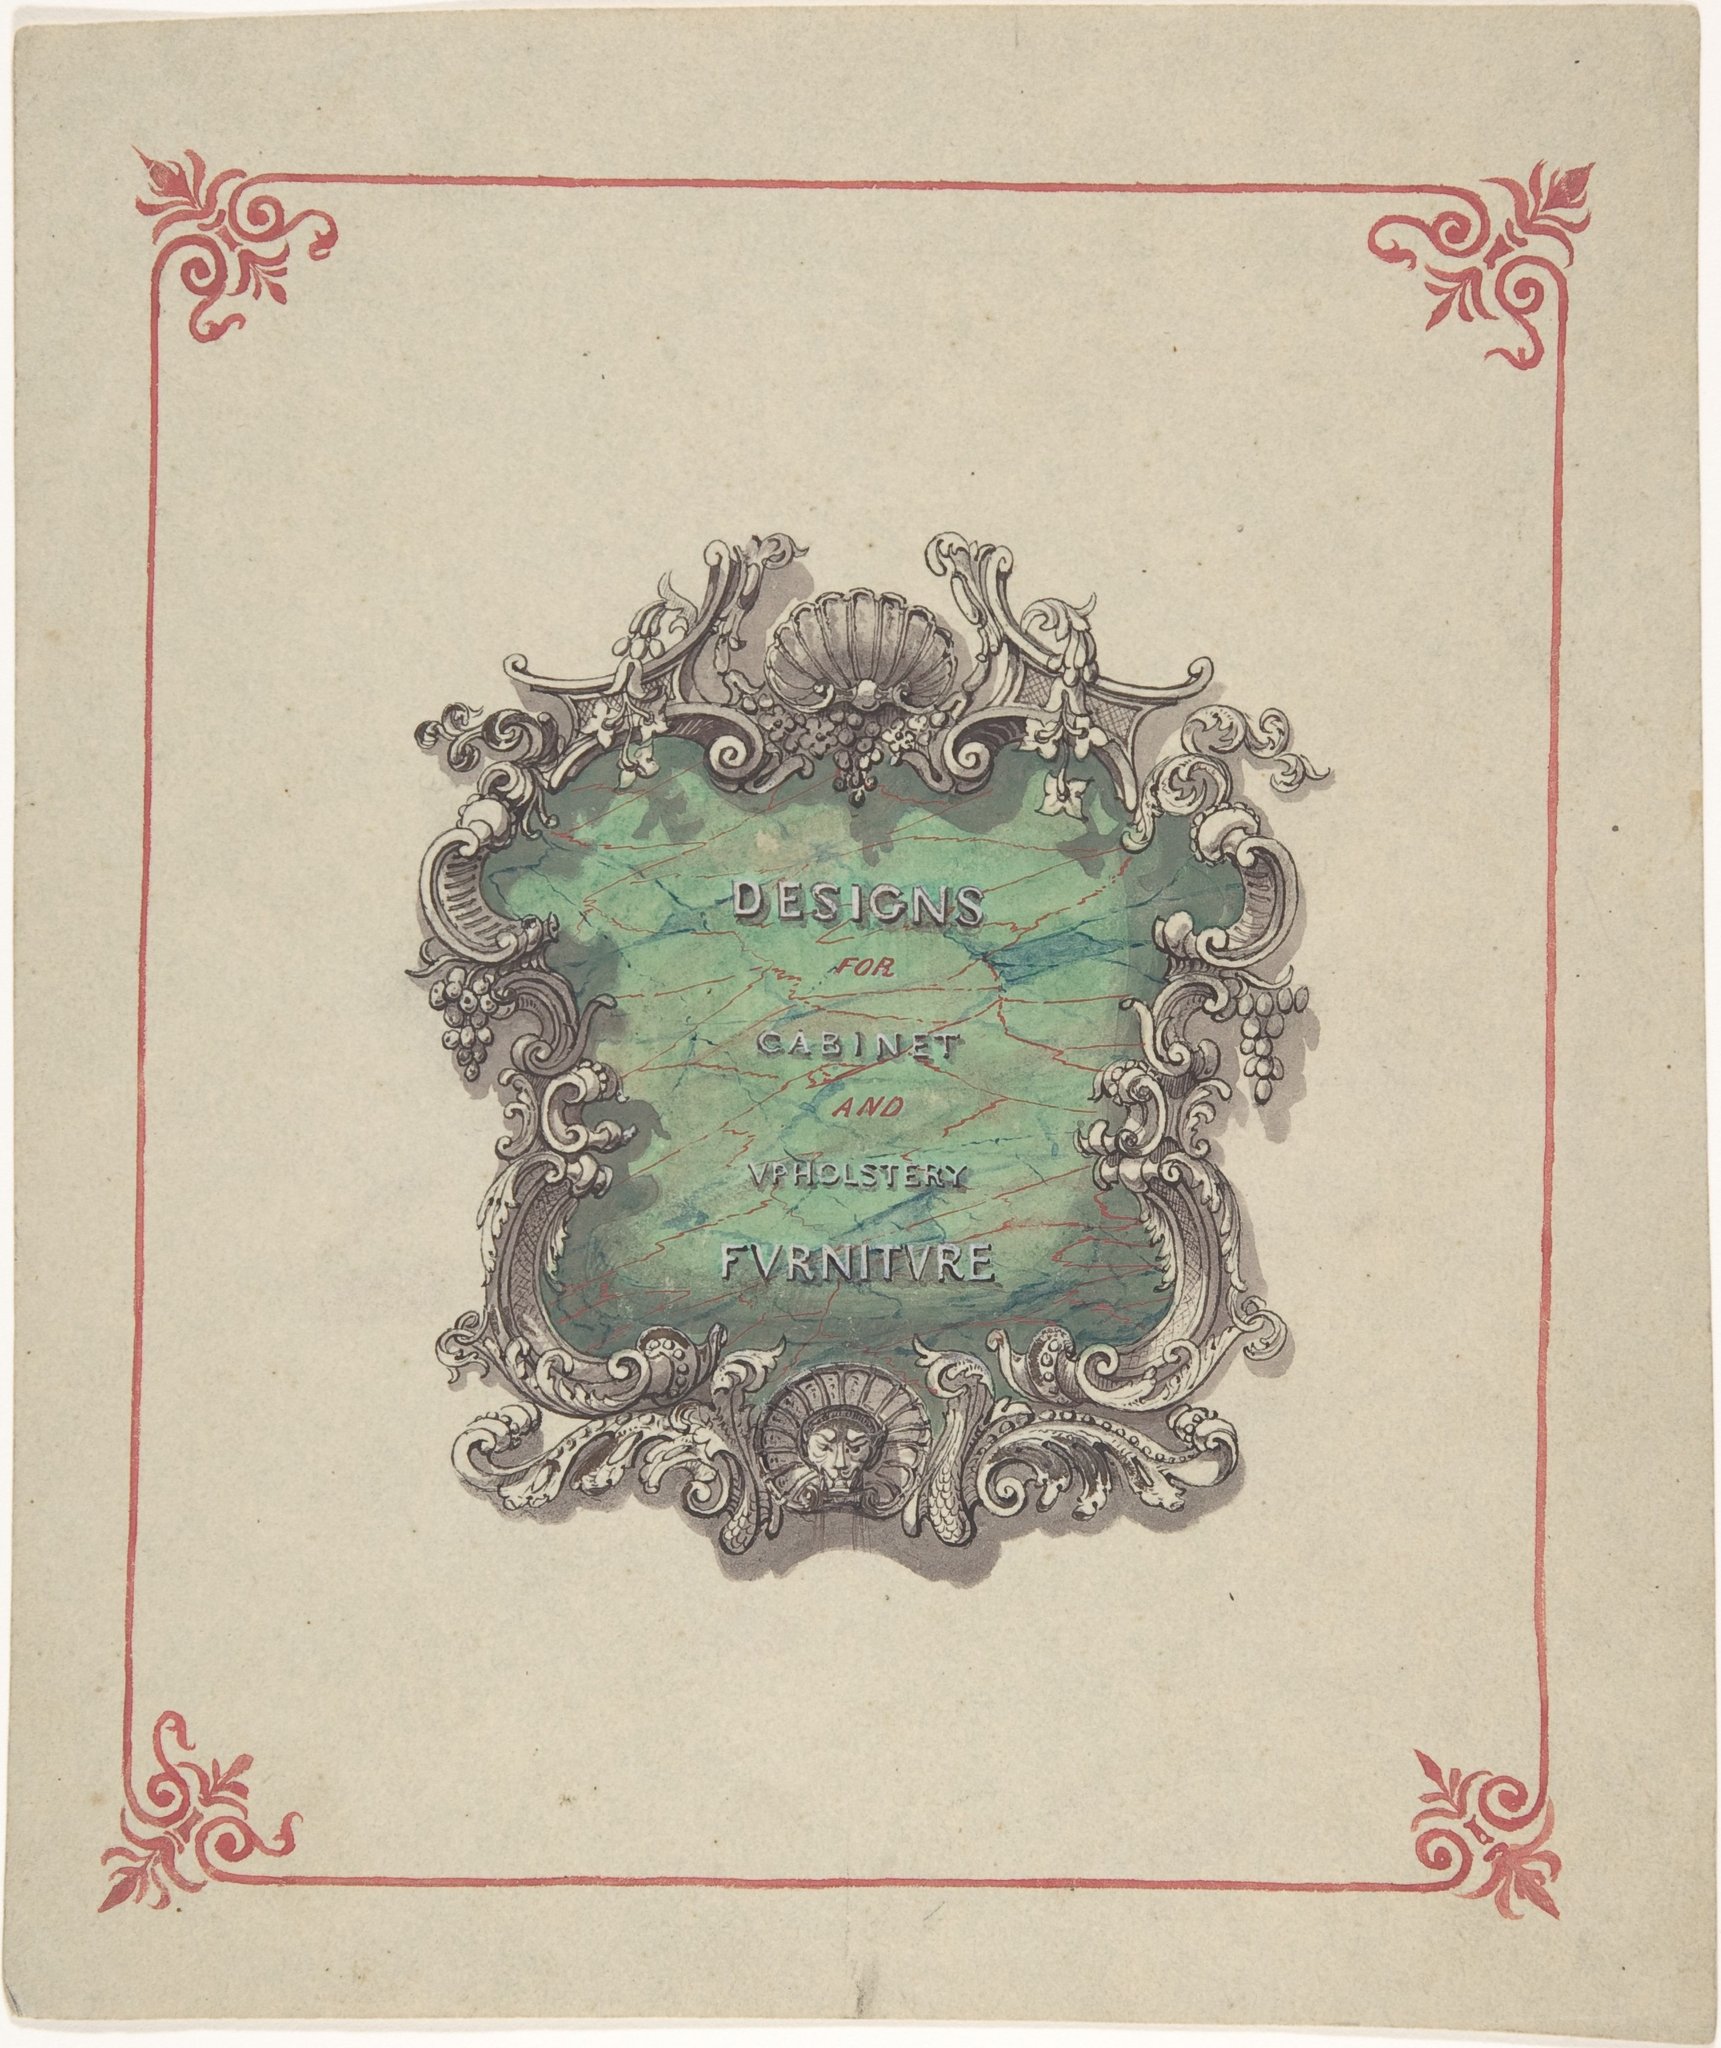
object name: drawing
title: Title Page Design: Designs for Cabinet and Upholstery Furniture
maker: robert william hume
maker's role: artist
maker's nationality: british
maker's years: 1816-1904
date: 1830-1900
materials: ink, watercolor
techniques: pen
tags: cartouches